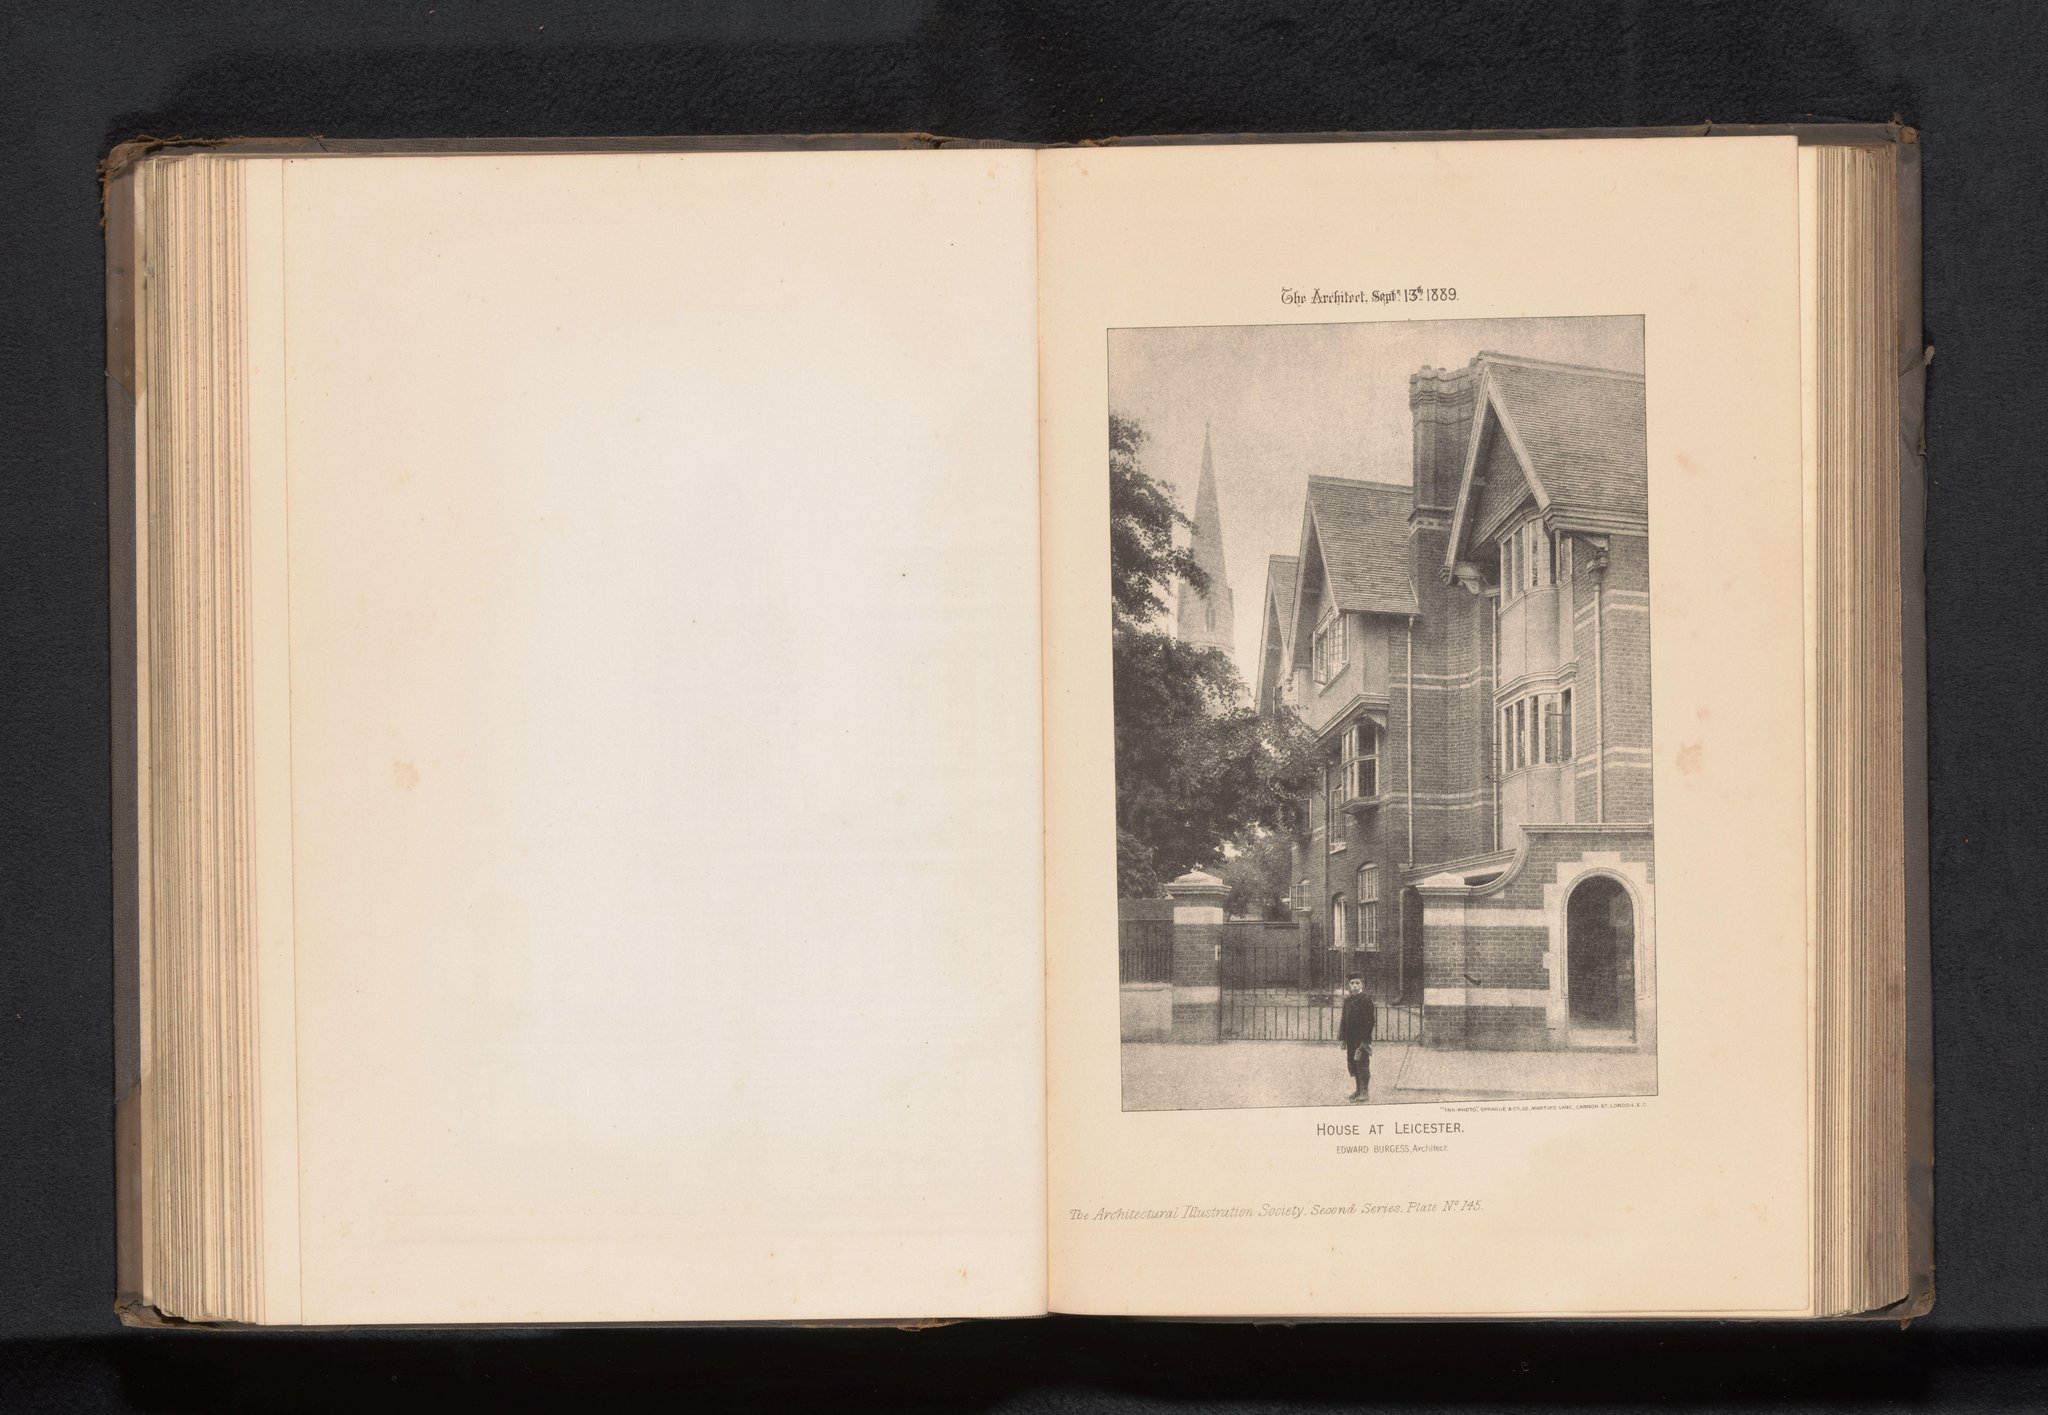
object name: page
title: Huizen te Leicester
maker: Anonymous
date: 1884-1889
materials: paper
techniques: photolithography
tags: urban housing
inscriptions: inscription: ‘Edward Burgess, Architect/ The Architectural Illustration Society. Second Series. Plate No. 145’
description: Prent op elfde ongenummerde pagina na pagina 148.